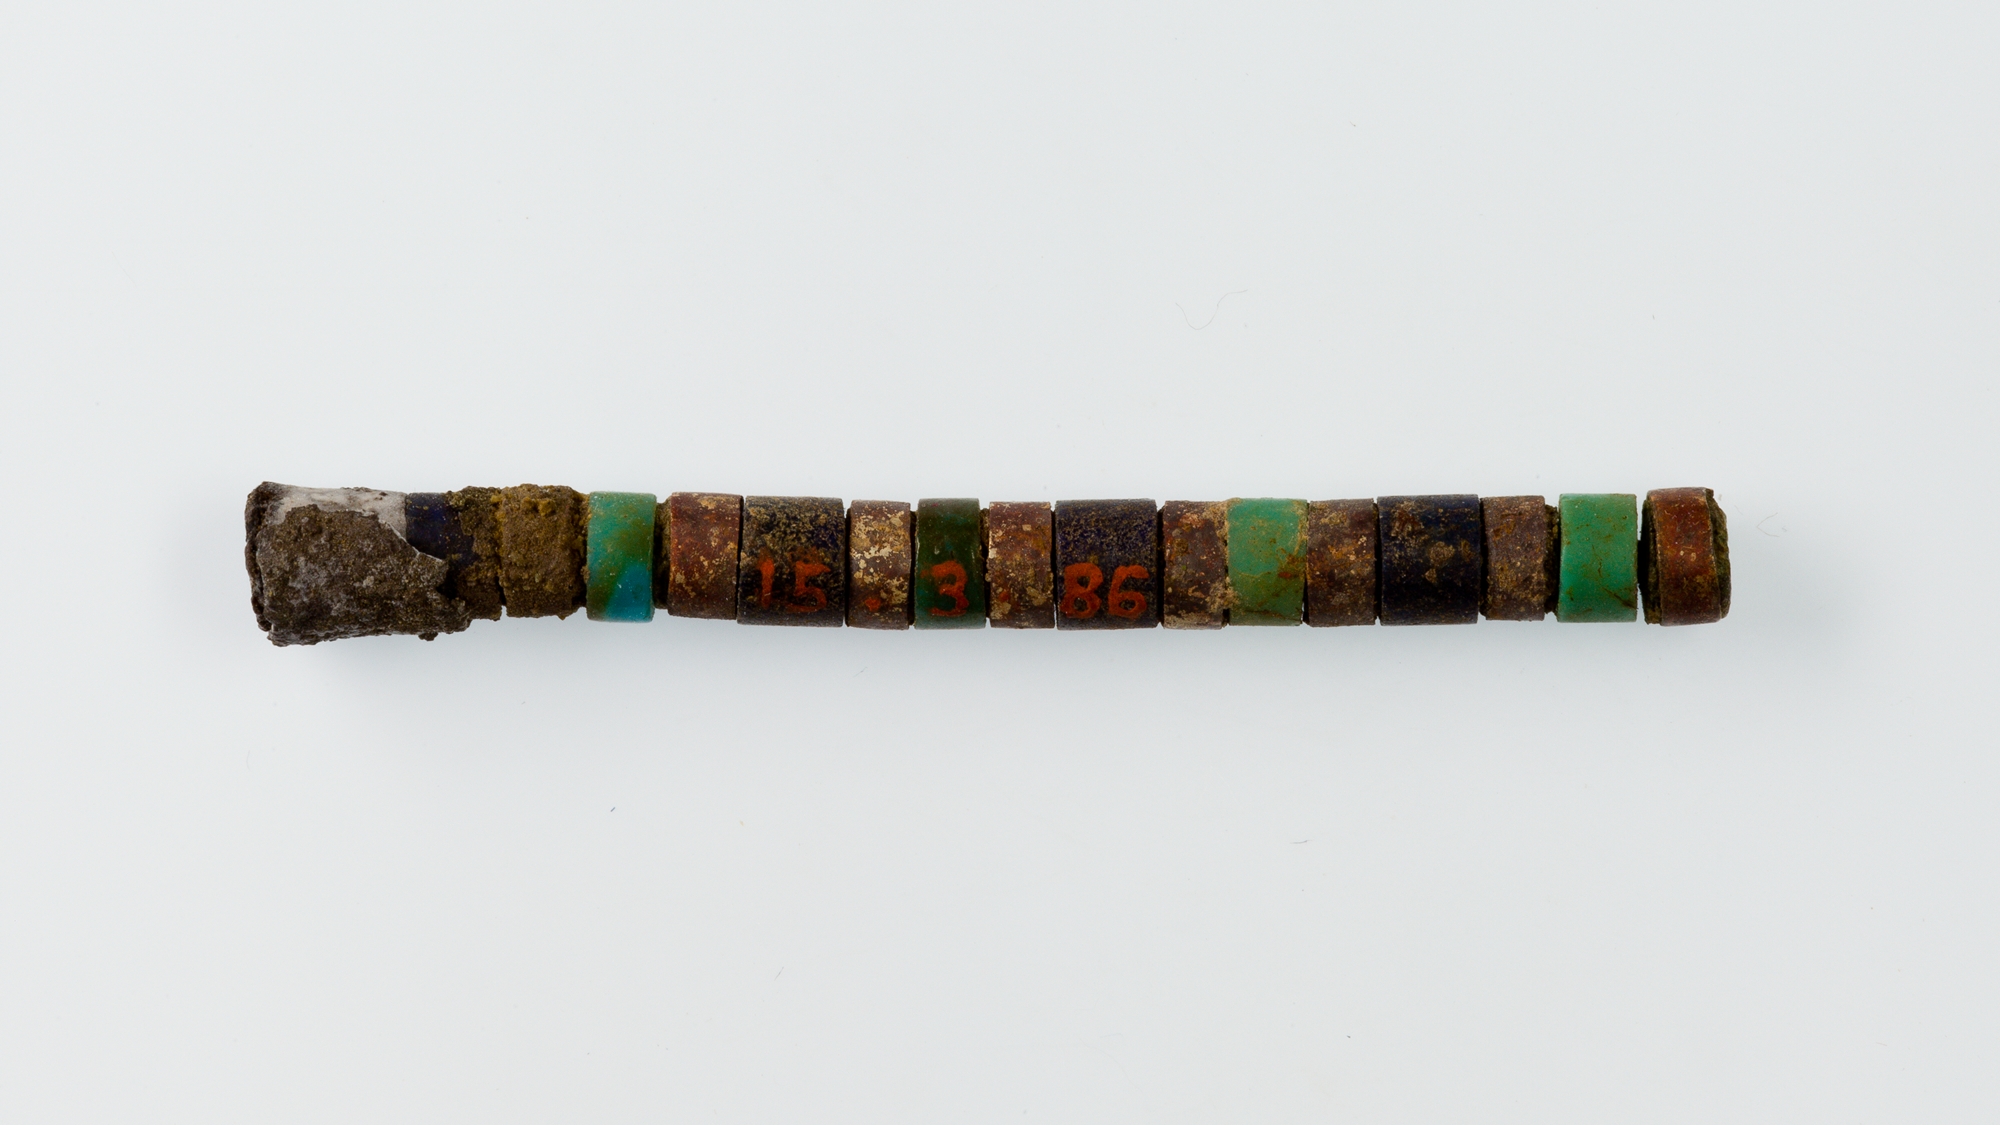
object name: necklace, bead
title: Bead or amulet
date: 1950-1804 BCE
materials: gold, jasper, lapis lazuli, wood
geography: egypt